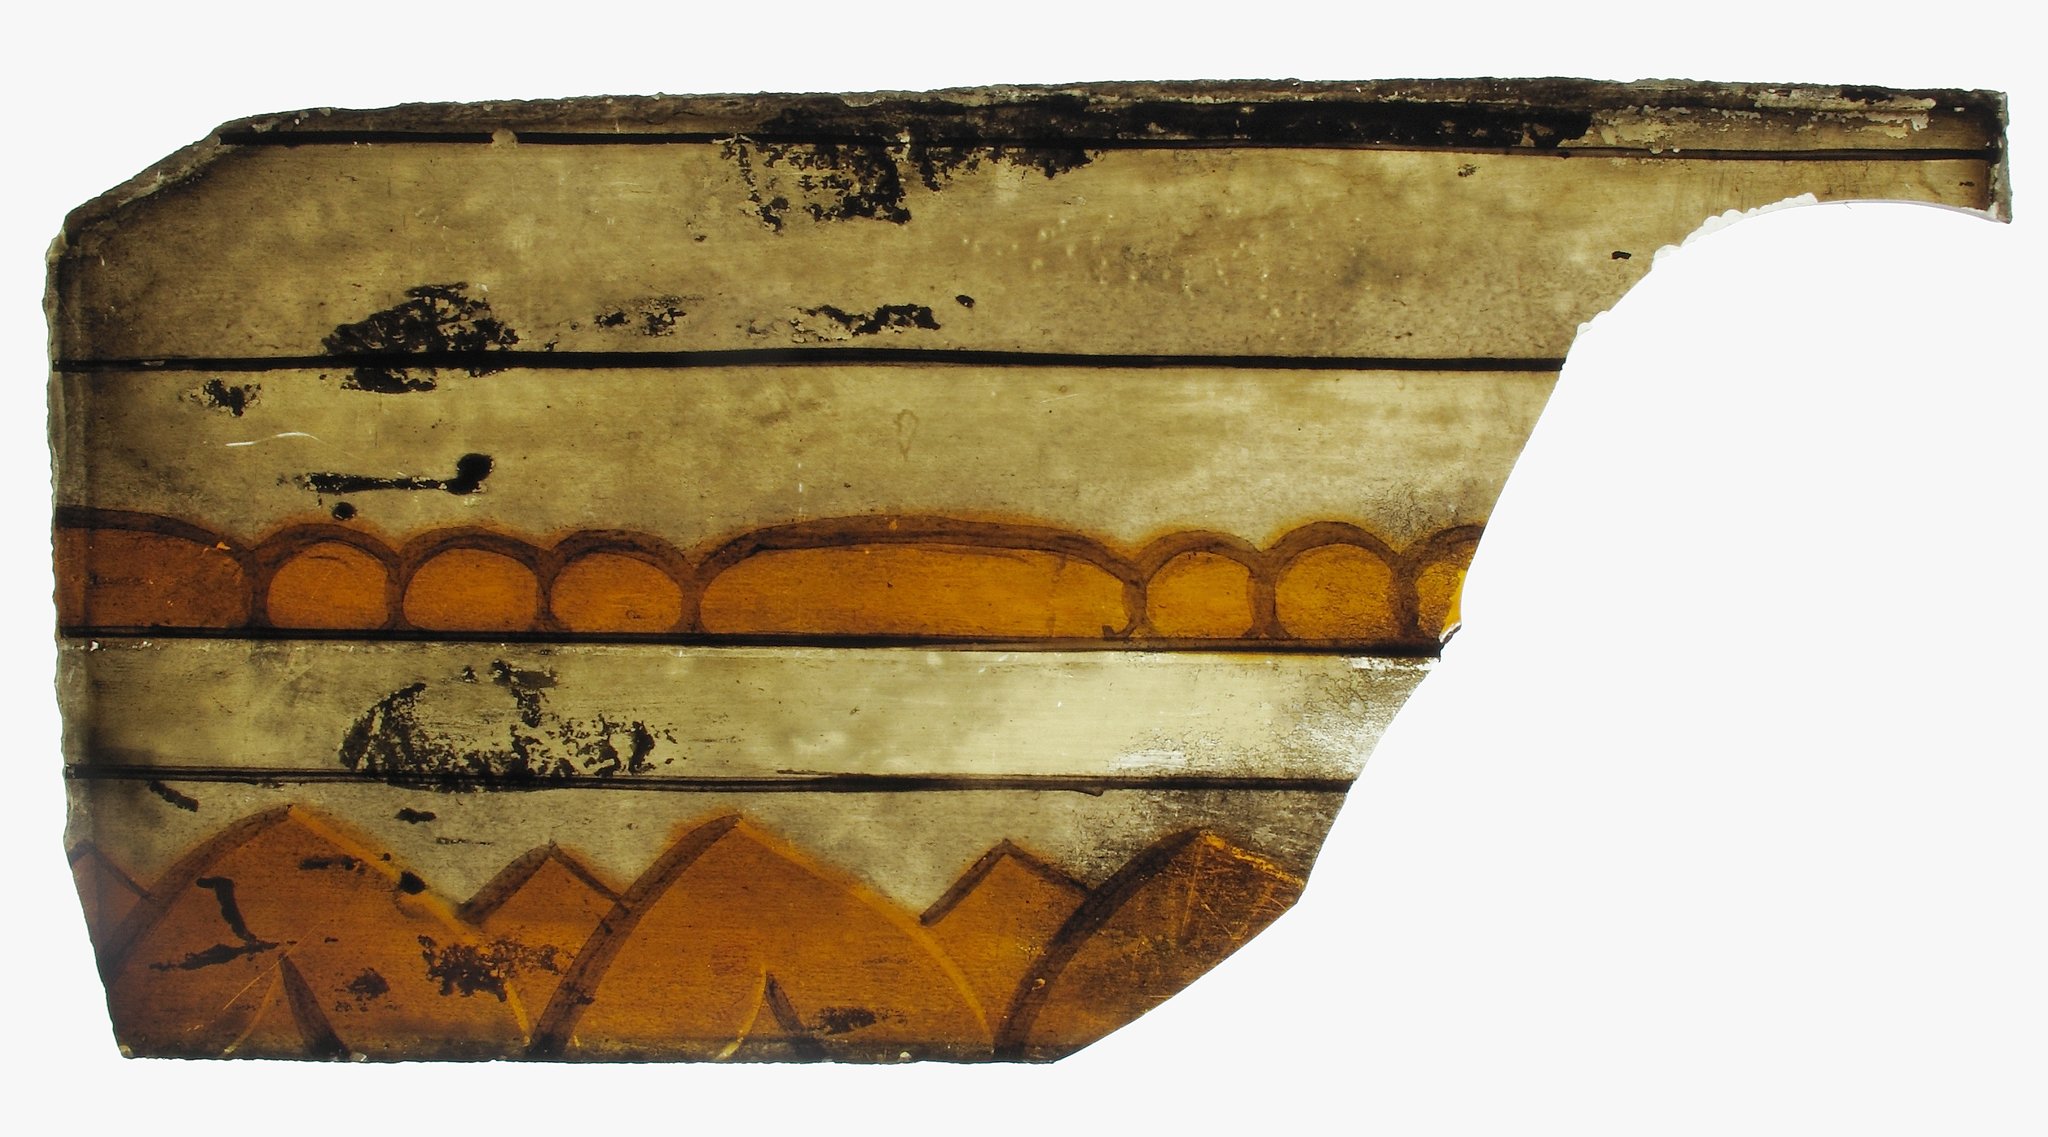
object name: fragment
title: Glass Fragment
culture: european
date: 1401-1600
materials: glass, paint, pigment